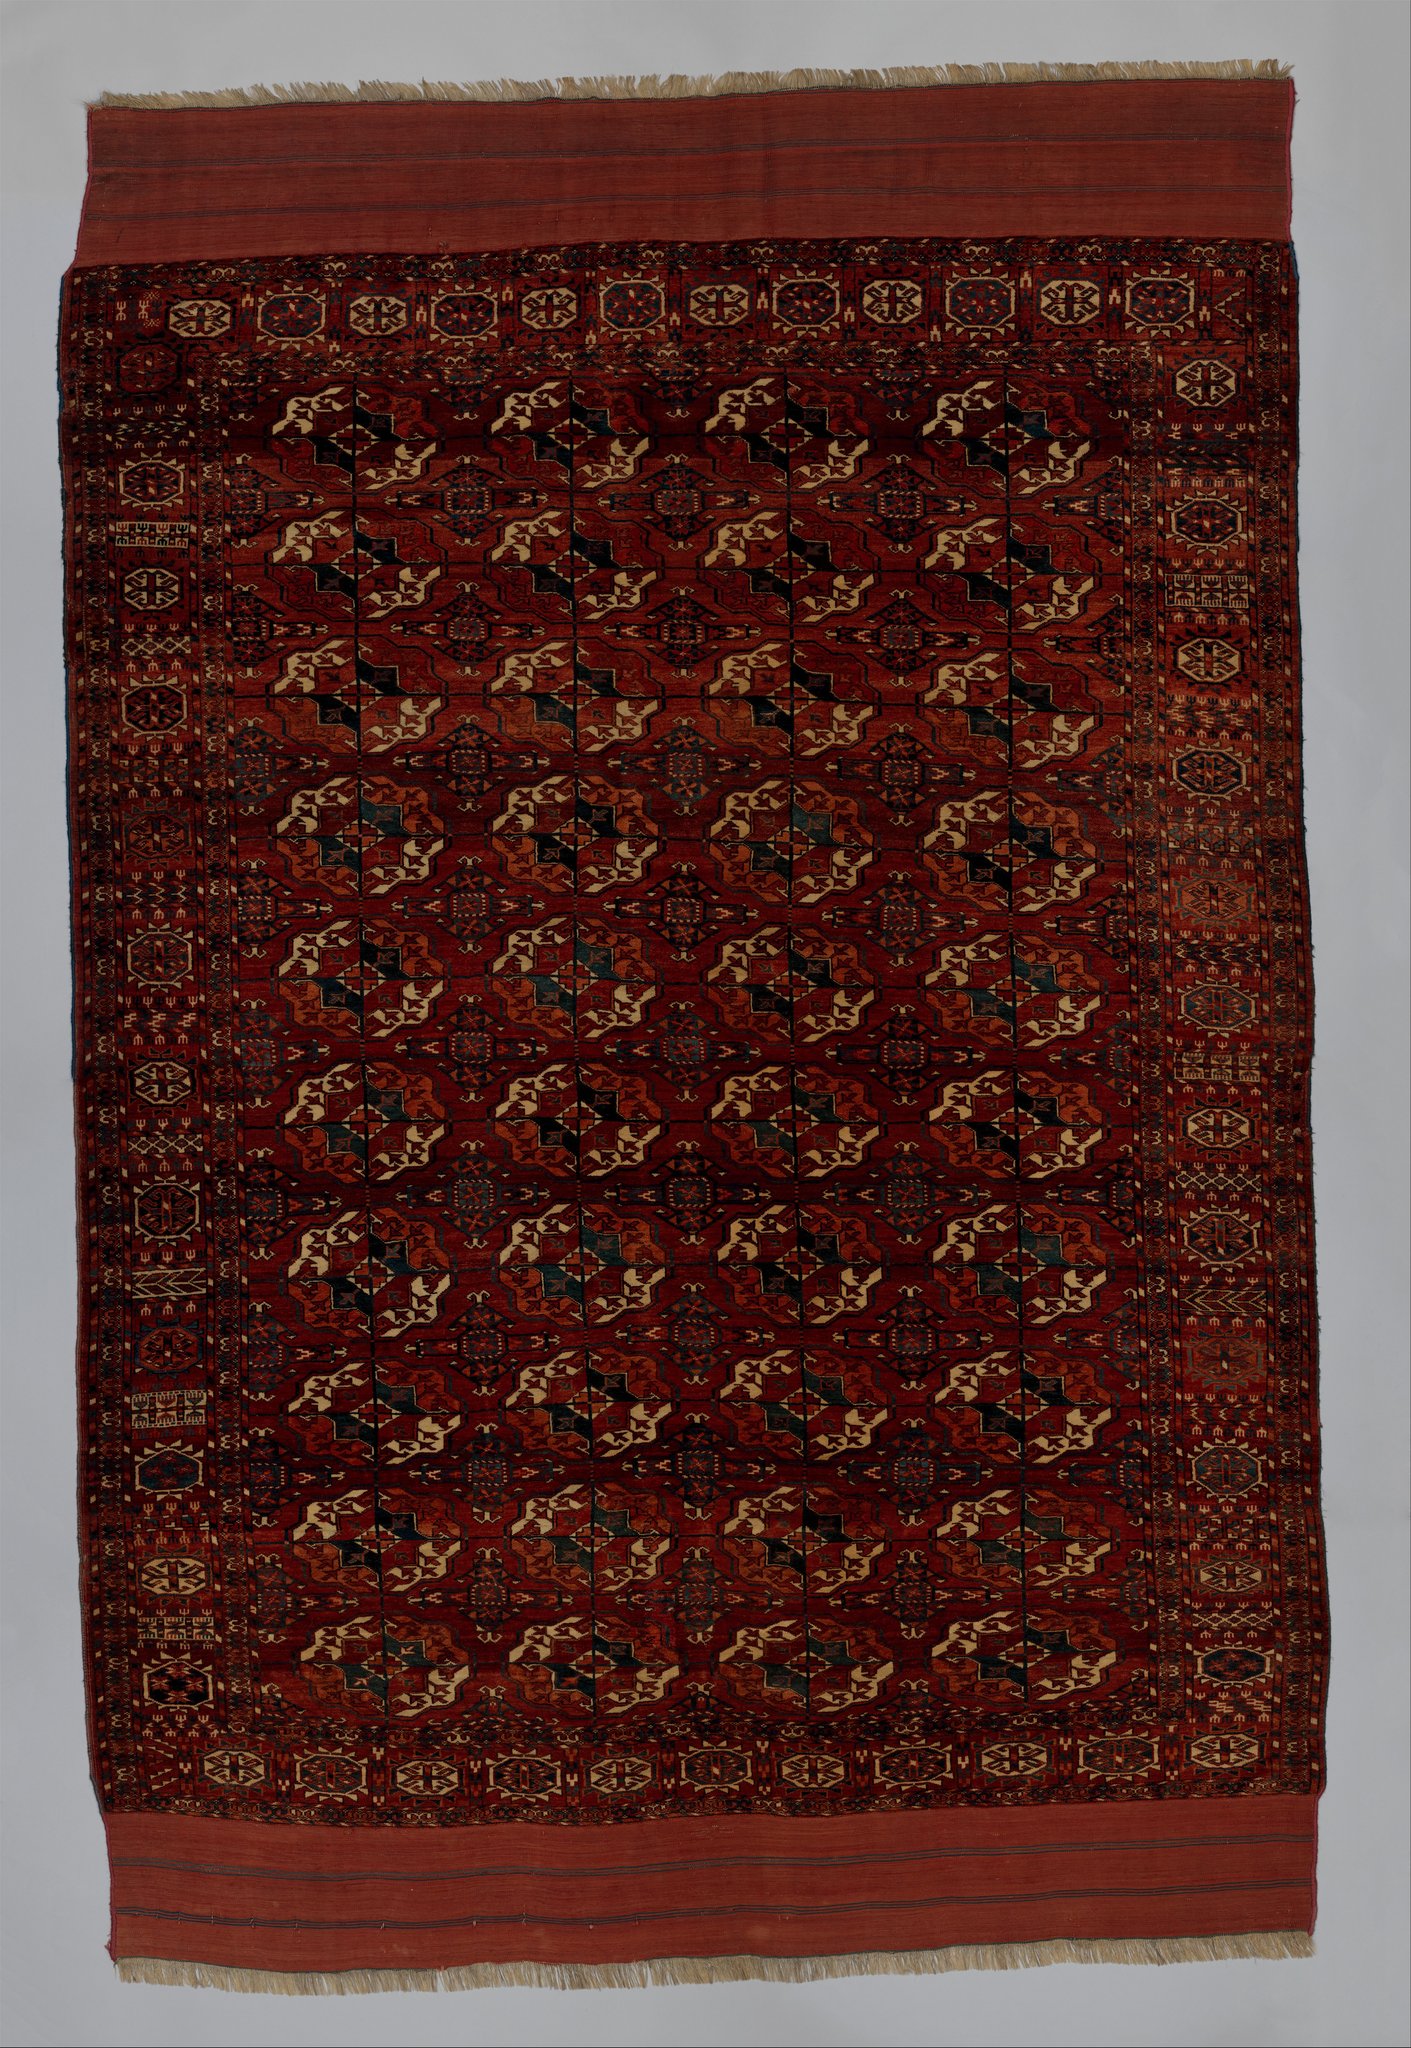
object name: carpet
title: Tekke Main Carpet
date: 1801-1833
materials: wool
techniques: asymmetrically knotted pile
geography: turkmenistan